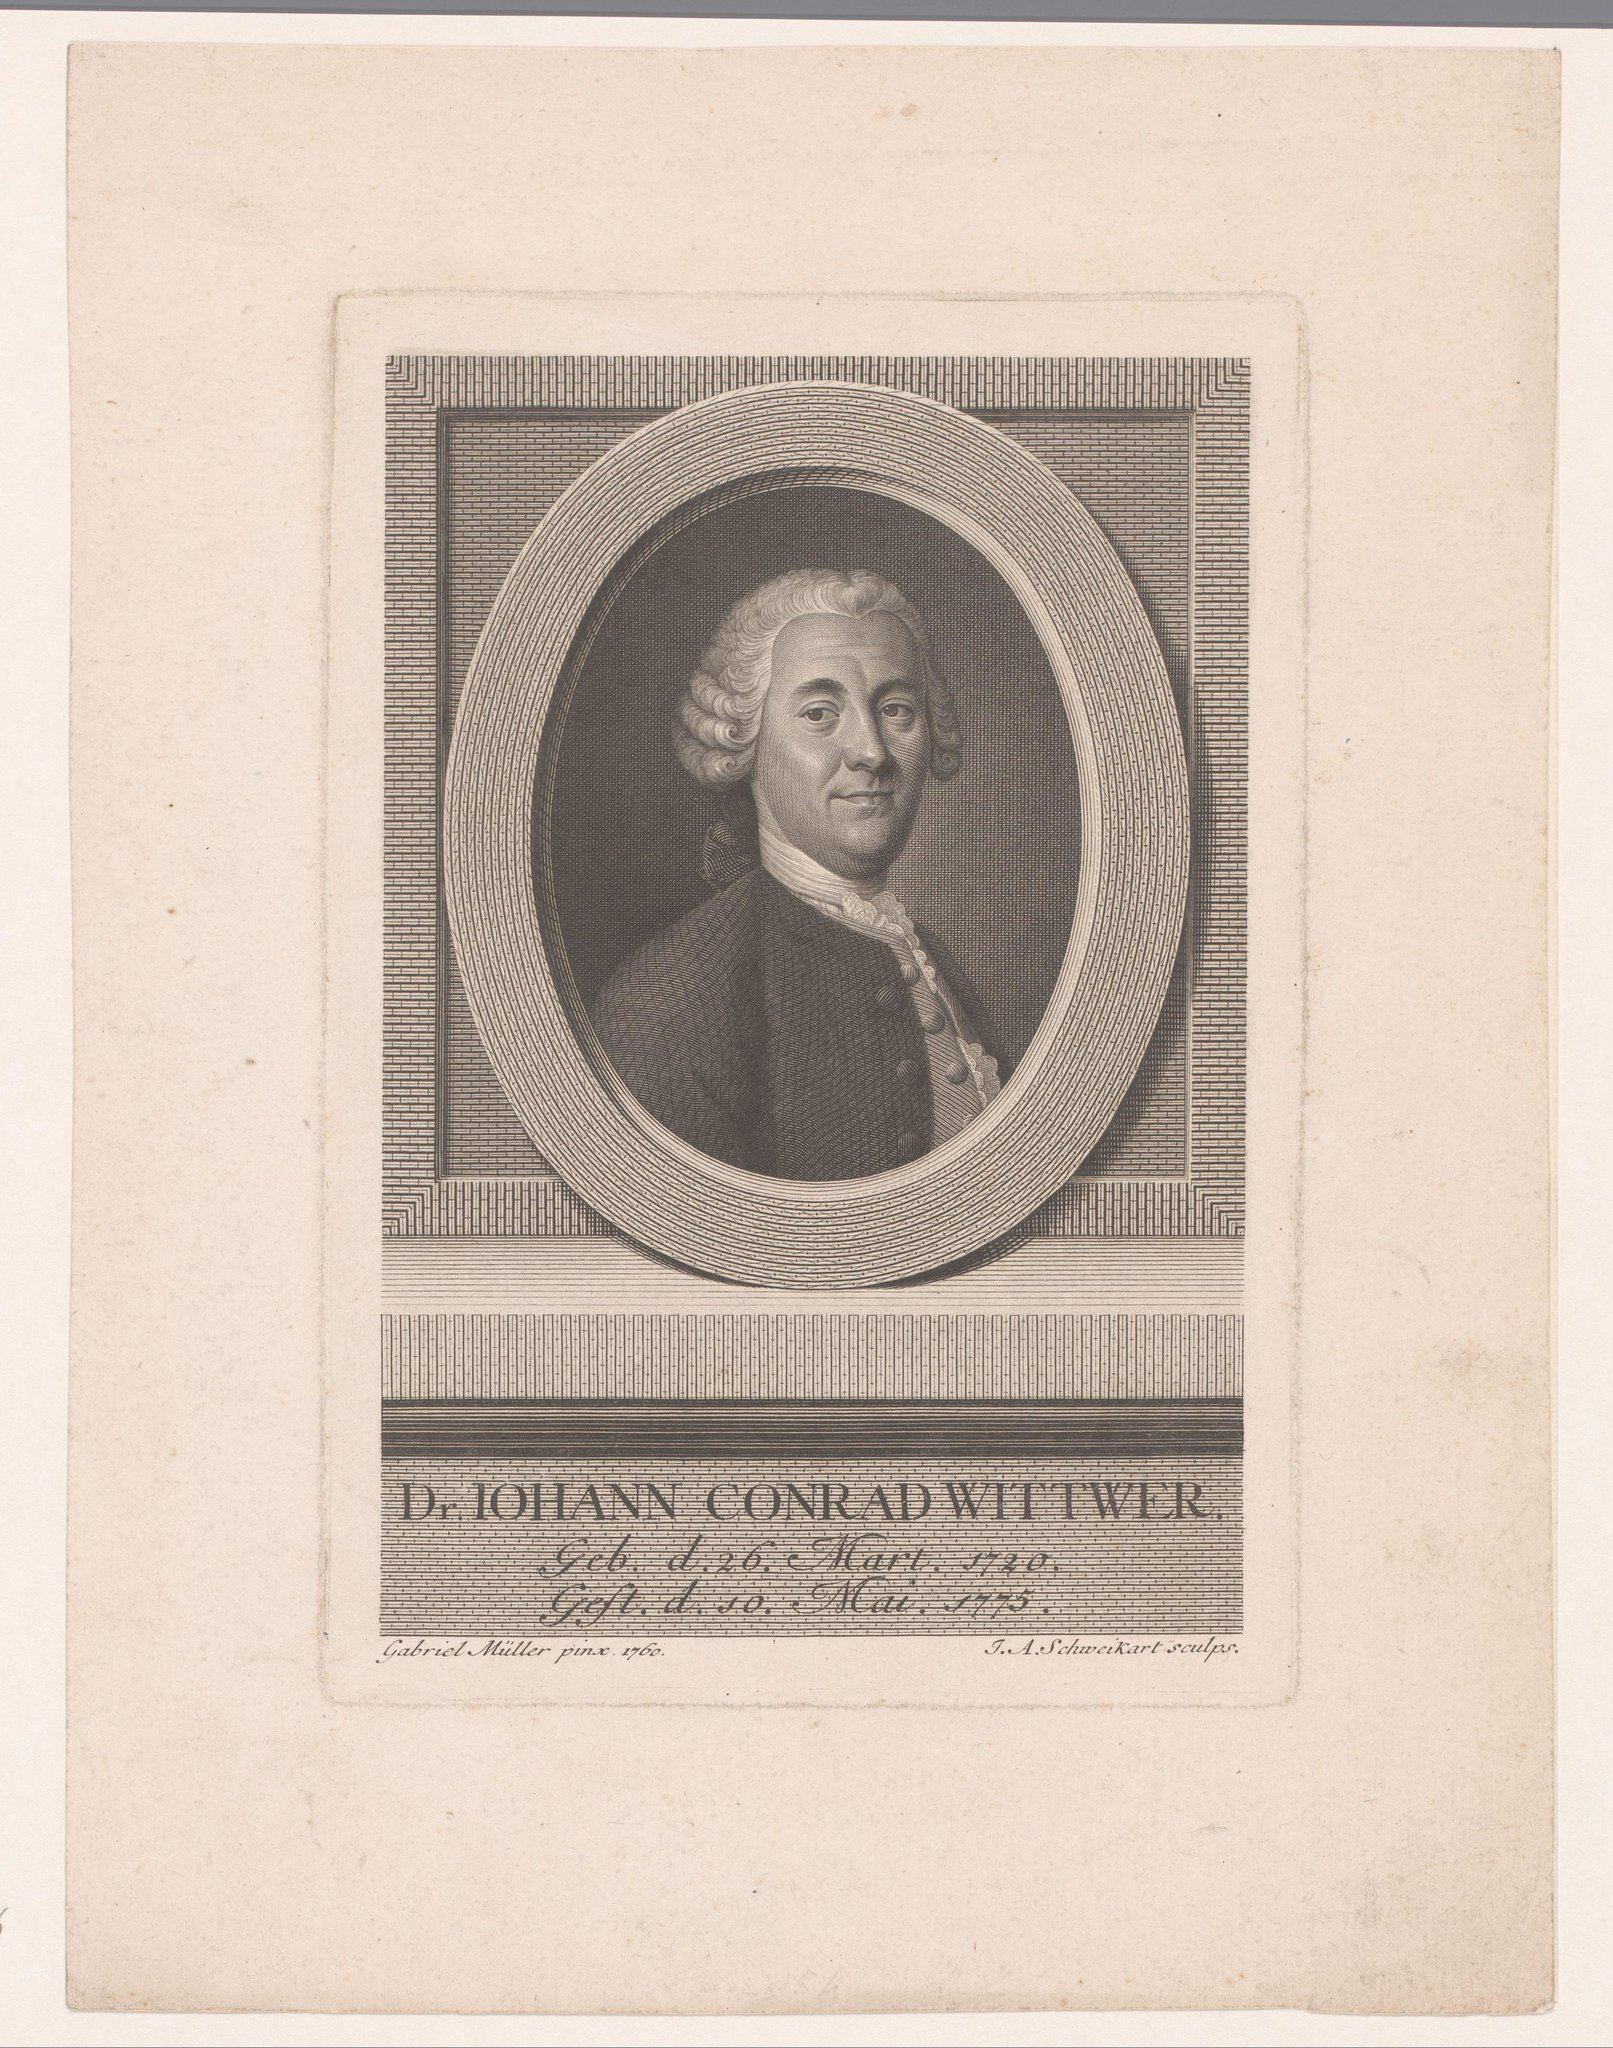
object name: print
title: Portret van Johann Conrad Wittwer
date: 1775-1787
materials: paper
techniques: engraving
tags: historical persons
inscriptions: collector's mark: Lugt 2228